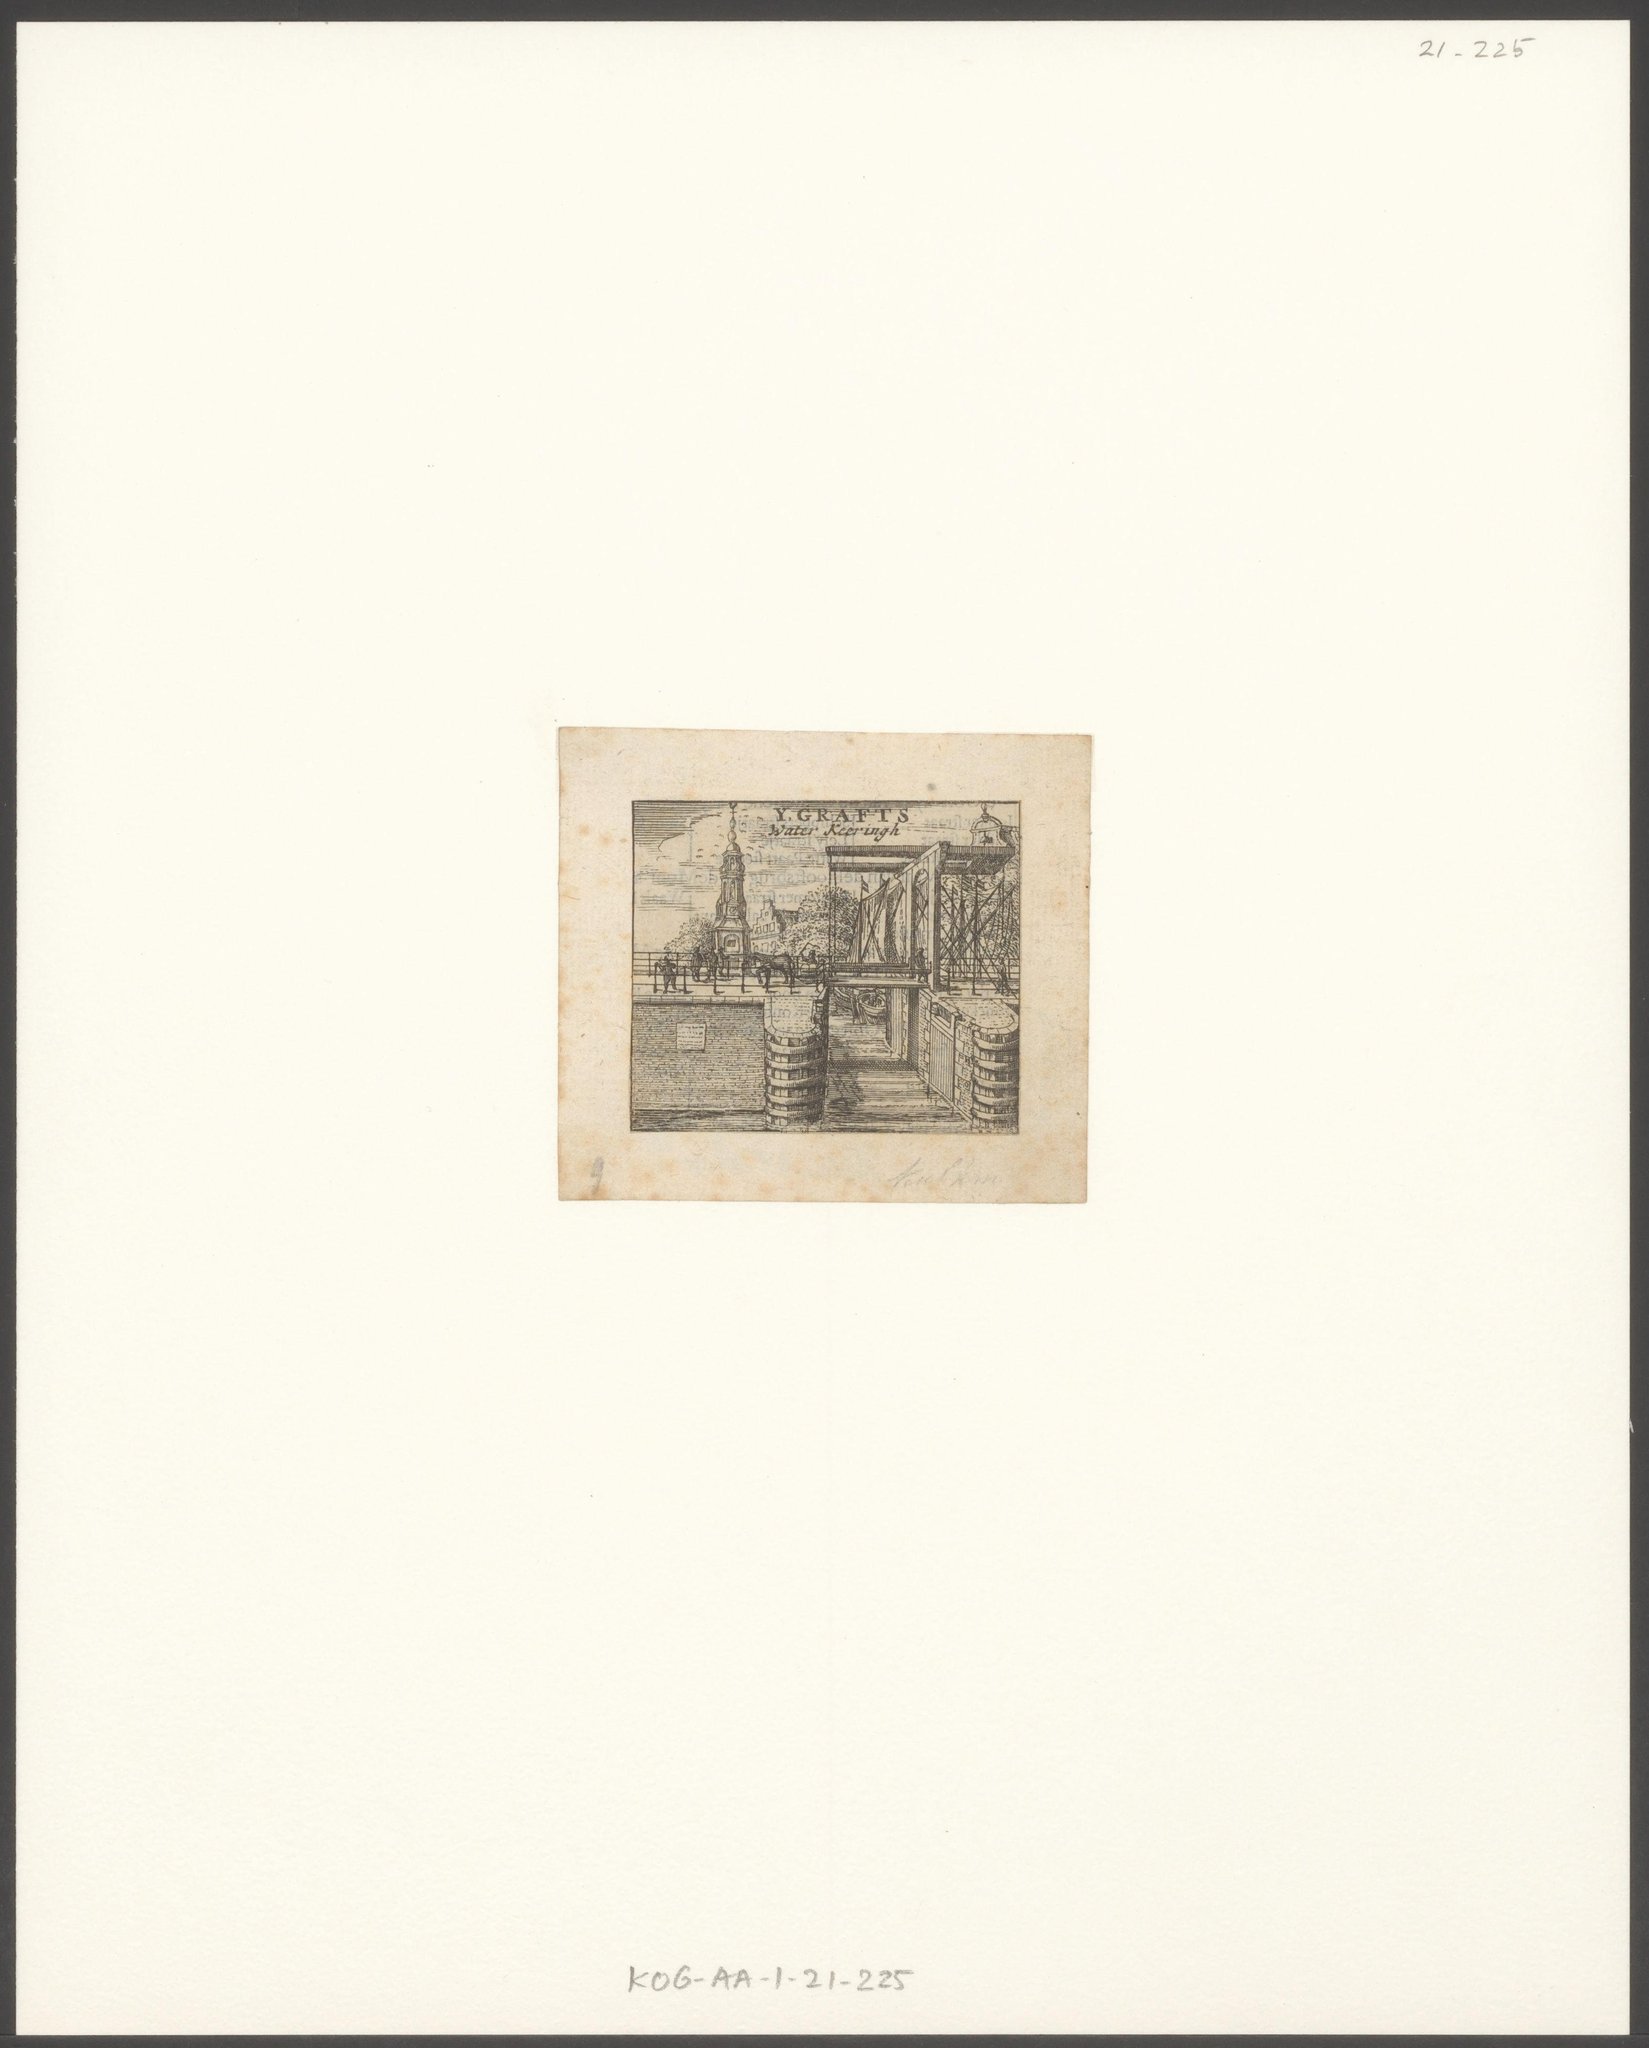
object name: print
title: Gezicht op de Peperbrug vanaf de Uilenburgergracht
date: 1713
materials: paper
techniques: etching, letterpress printing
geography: amsterdam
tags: sluice, weir, canals, waters (in city), bridge in city across river, canal, etc.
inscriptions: collector's mark: Lugt 1641b, inscription: ‘Acta D.C. [...]’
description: Prent mogelijk uit: Beknopte beschryving van alle de voornaamste Gebouwen der wydvermaarde Koopstad Amsterdam, Cierlyk in 't Koper afgebeeld, inzonderheid van het Stadhuis (...). Amsterdam: Dirk Schouten, 1713. Of uit: Beknopte beschryving van alle de voornaamste Gebouwen der wydvermaarde Koopstad Amsterdam, Cierlyk in 't Koper afgebeeld, inzonderheid van het Stadhuis (...). Amsterdam: Jan (II) Roman, 1741. Of uit: Beknopte beschryving van alle de voornaamste Gebouwen der Wydvermaarde Koopstad Amsterdam, Cierlyk in 't Koper afgebeeld, inzonderheid van het Stadhuis (...). Amsterdam: Jan (II) van der Heyden, 1749.